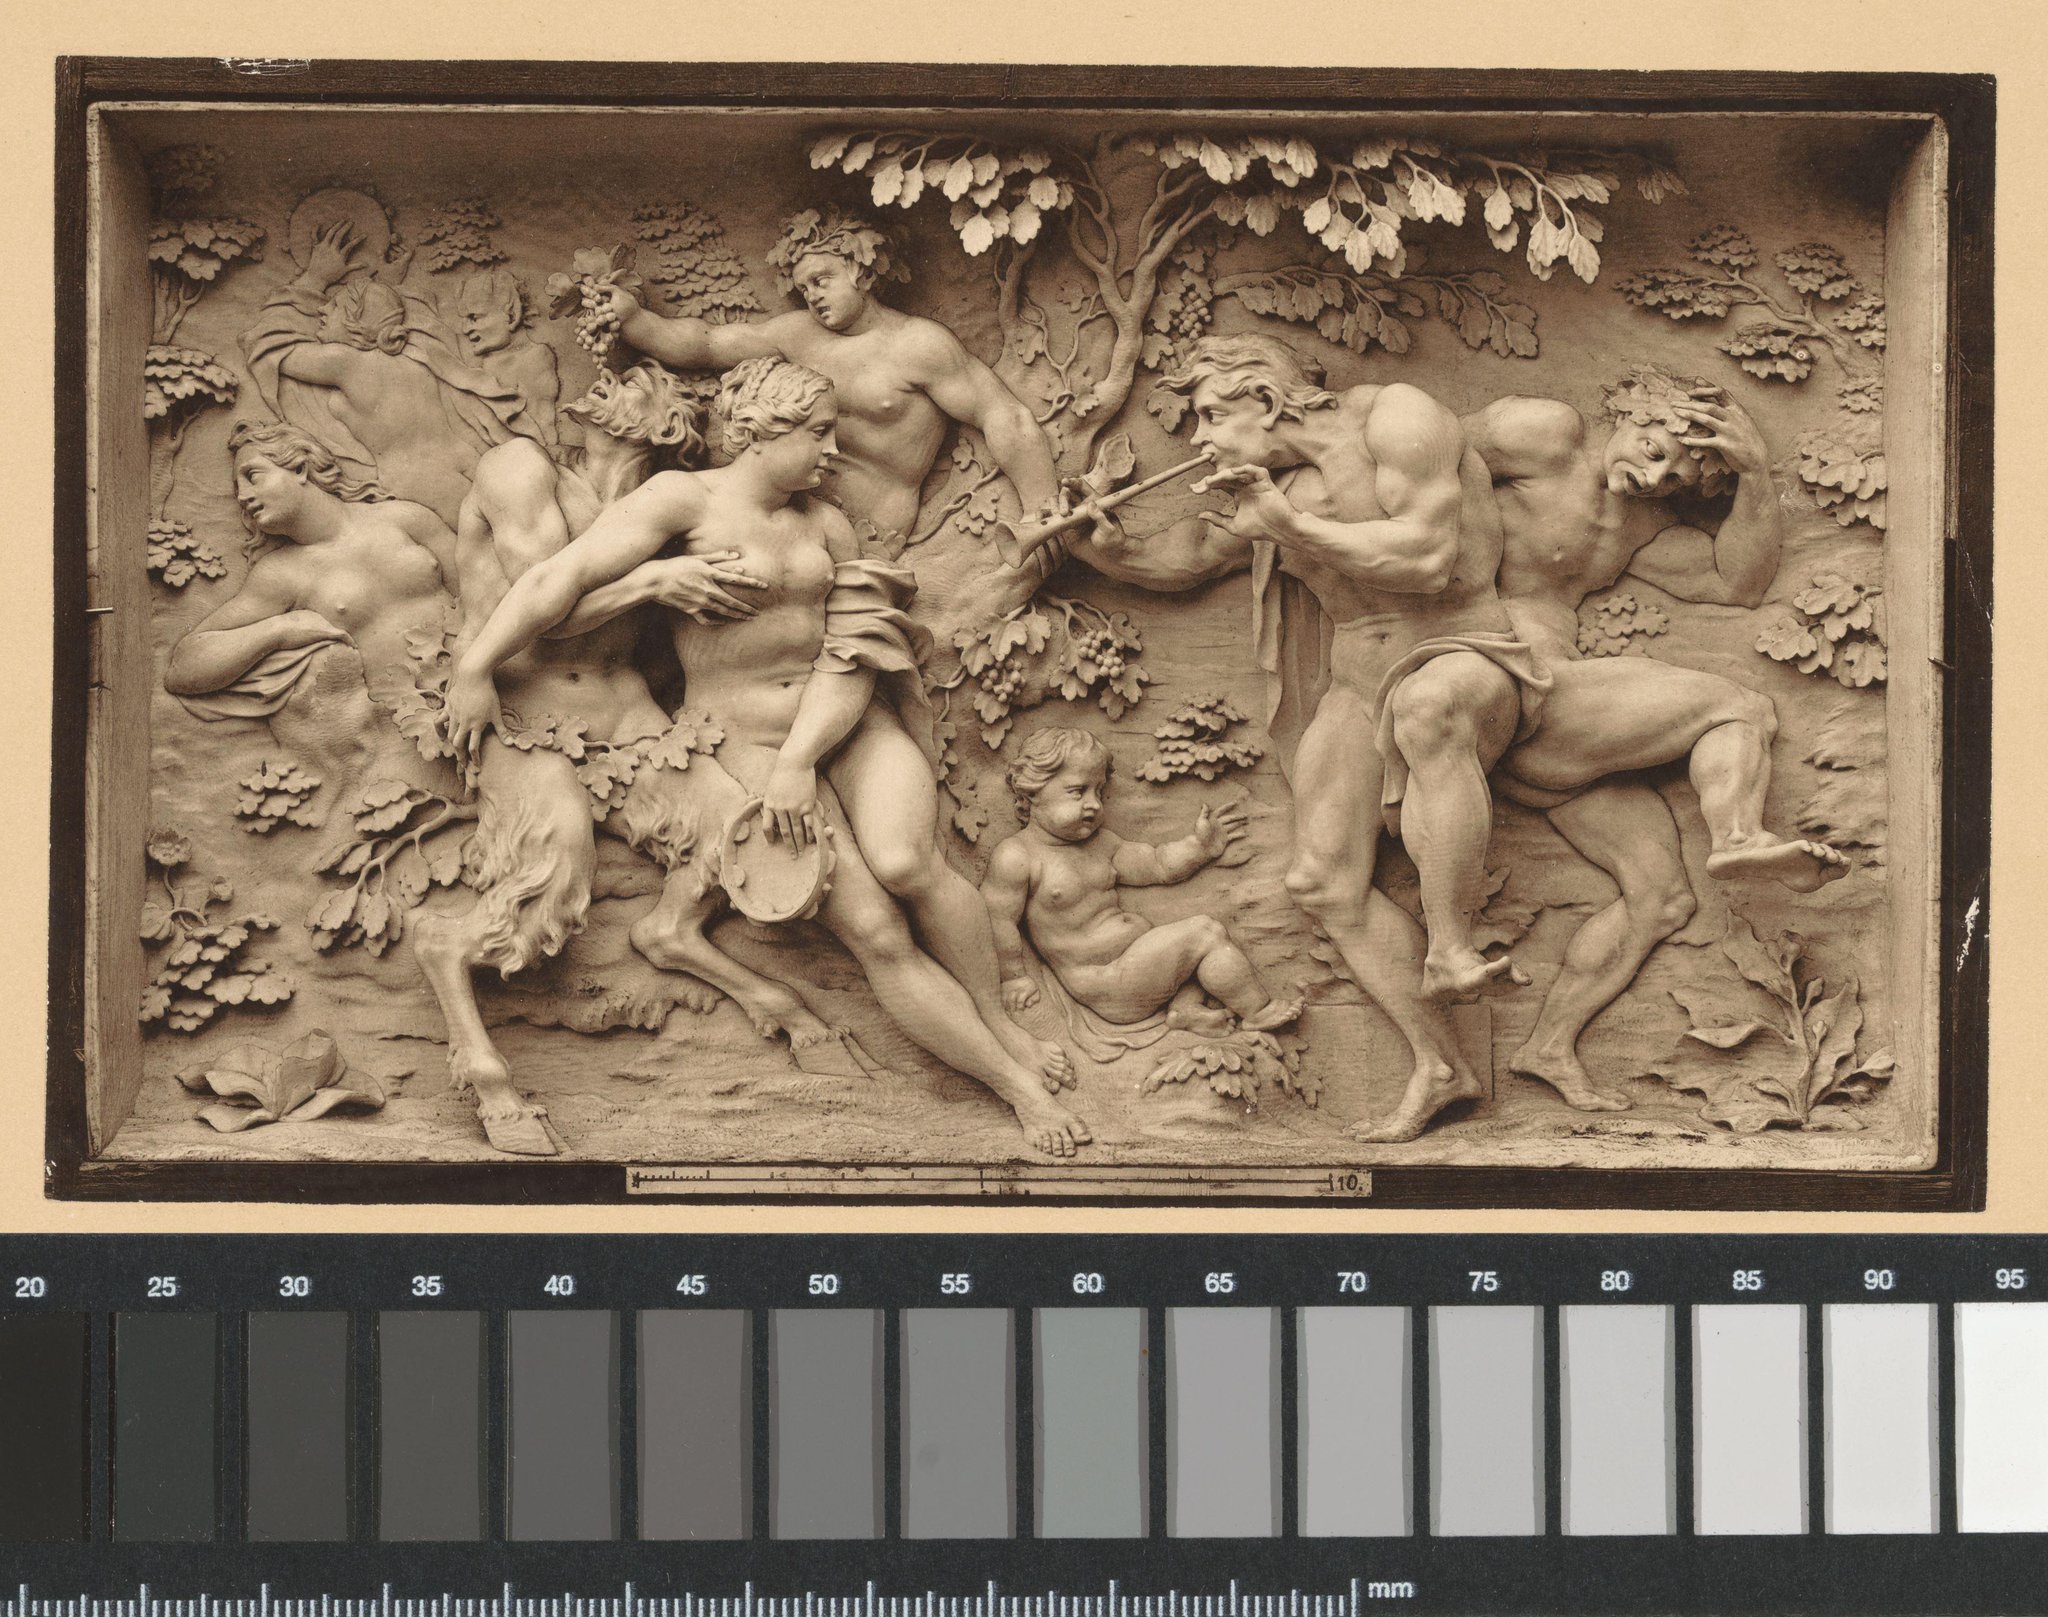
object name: photomechanical print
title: Reliëf uit ivoor met voorstelling van een bacchanaal, door Ignaz Elhafen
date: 1869-1887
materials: cardboard, paper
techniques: photograph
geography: munich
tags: bacchanal: bacchus with his wine-flushed train (thiasos), piece of sculpture, reproduction of a piece of sculpture, germany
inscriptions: number: ‘Blatt 190.’